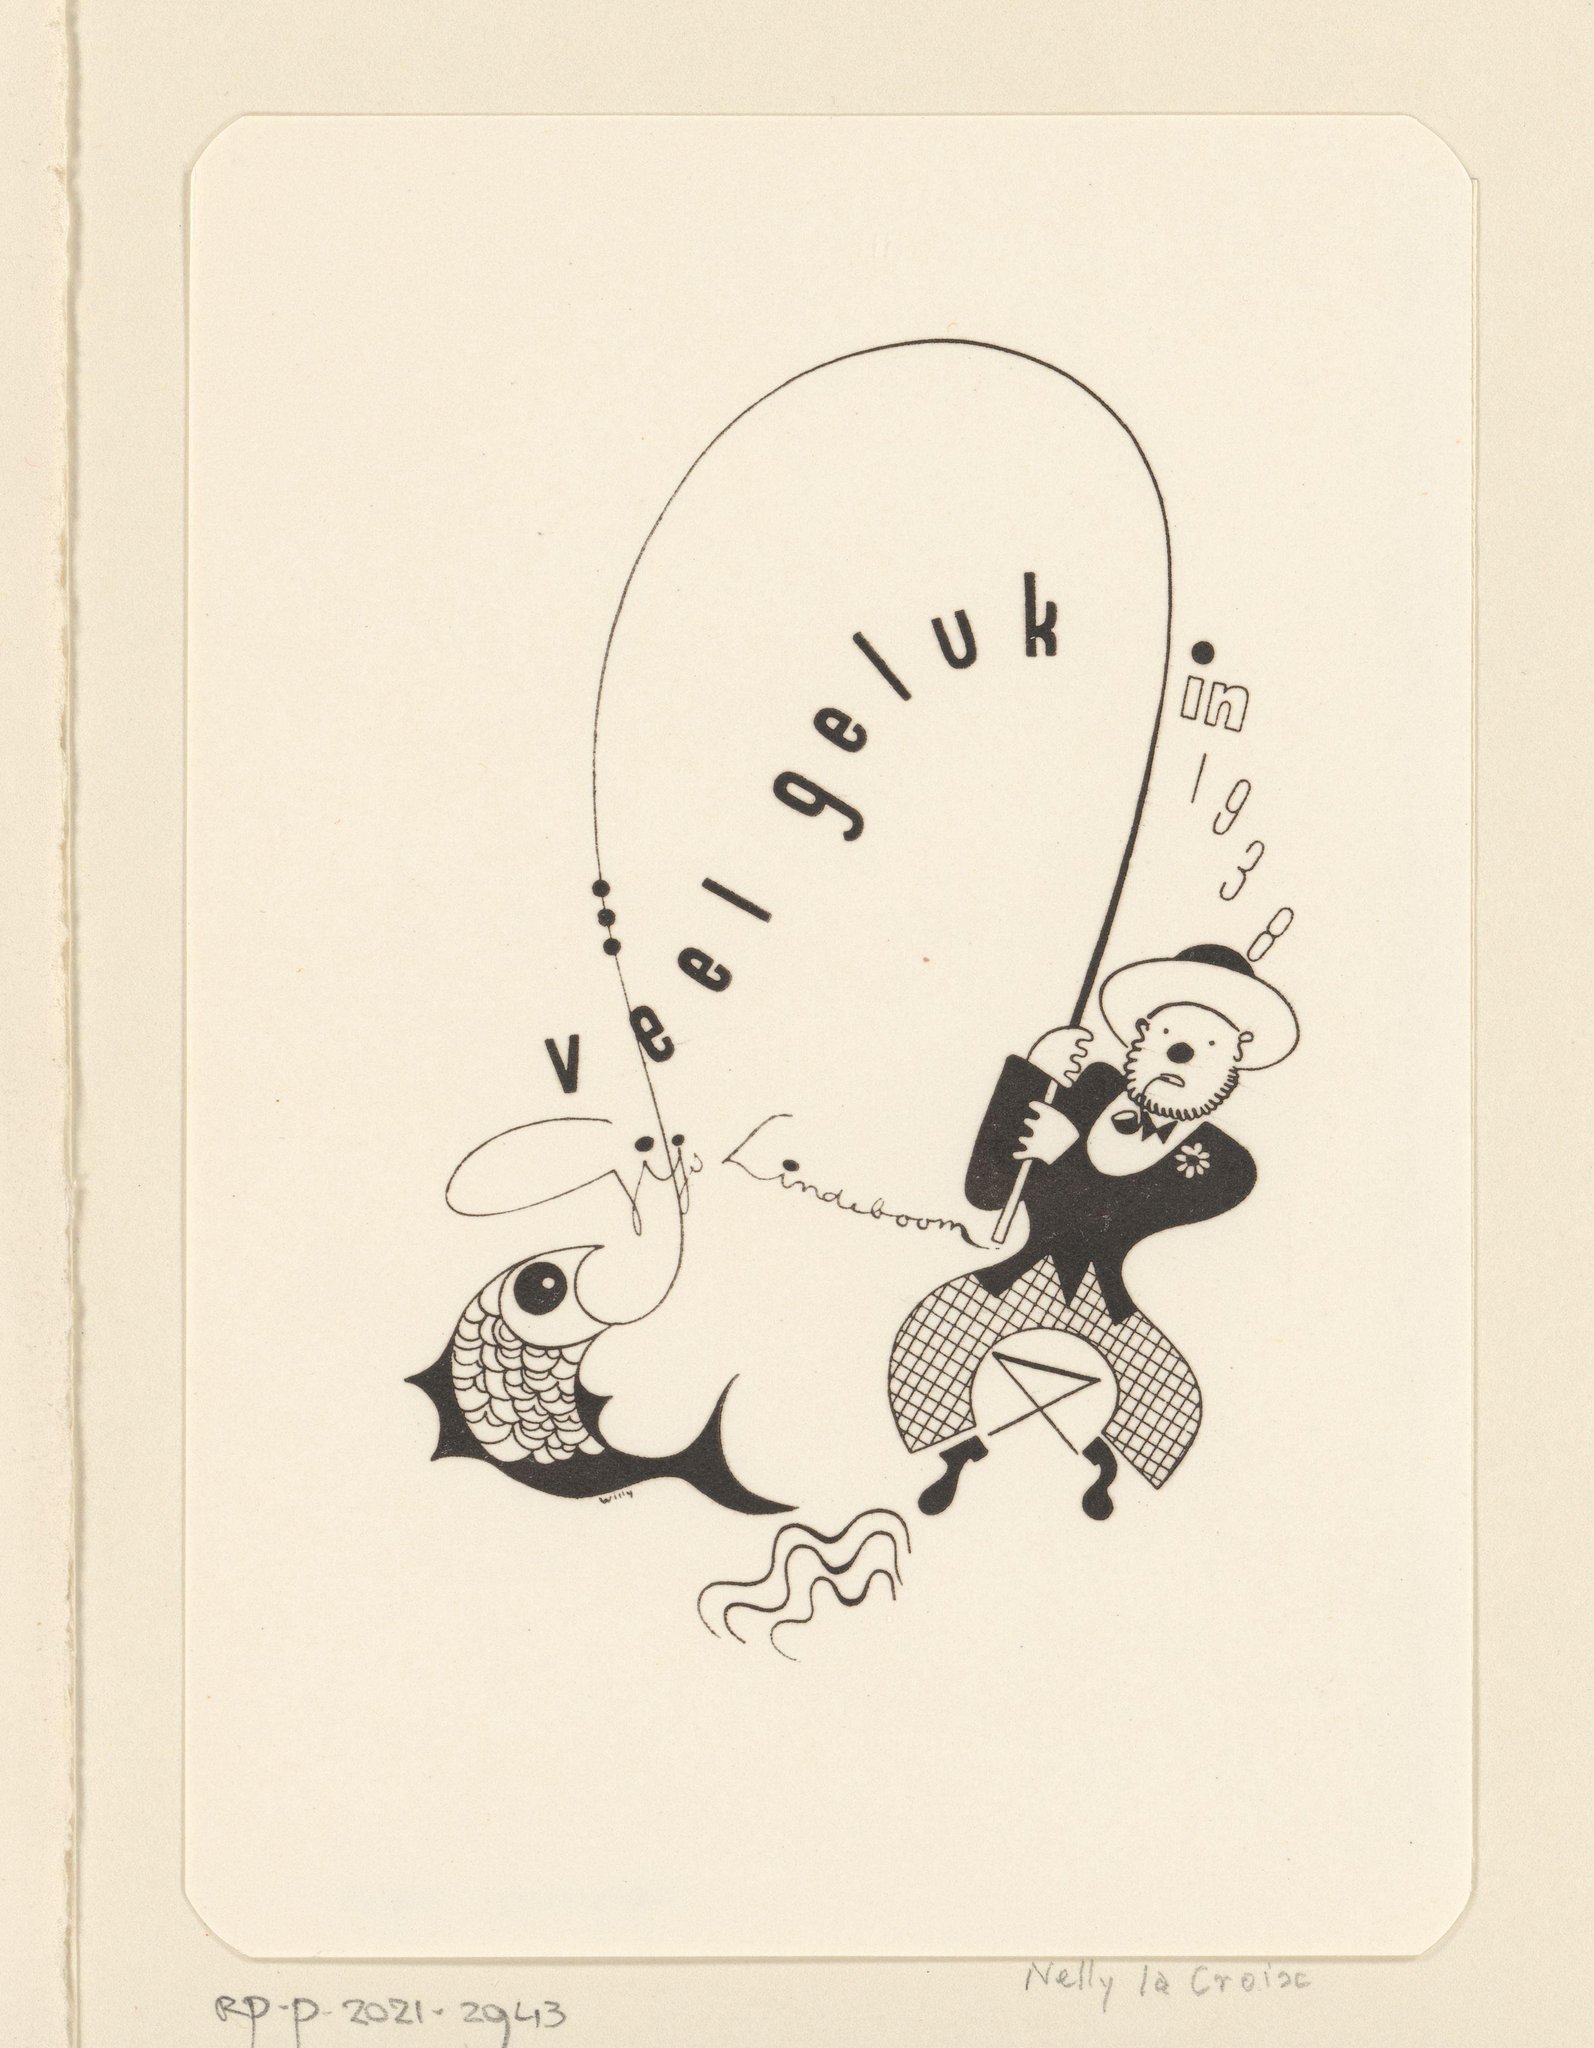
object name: photomechanical print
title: Nieuwjaarswens voor 1938 van Gijs Lindeboom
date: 1937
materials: paper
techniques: printing block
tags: angling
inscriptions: date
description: Een pijprokende visser heeft een forse vis aan de haak geslagen. Met de tekst: 'Veel geluk in 1938'.